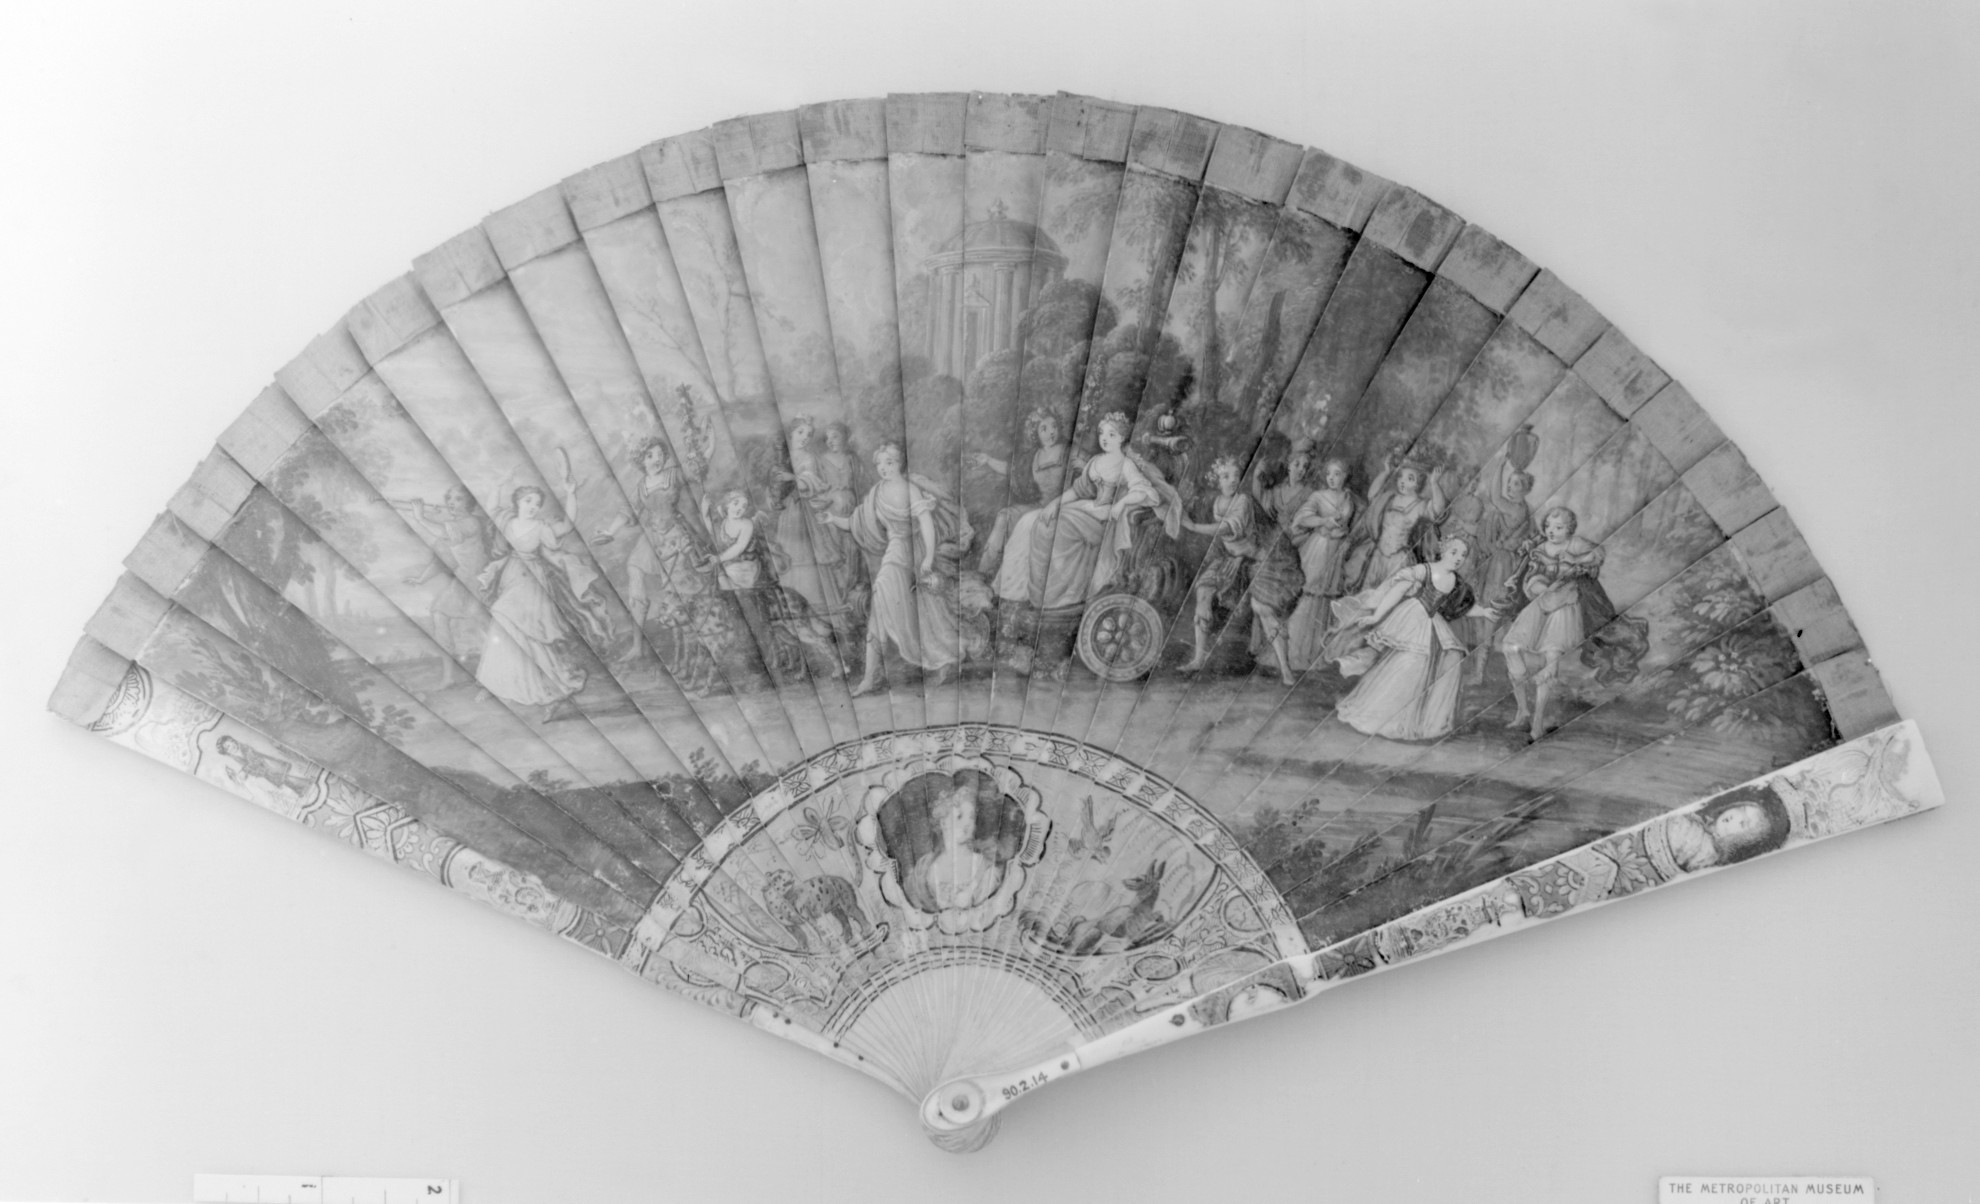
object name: fan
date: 1701-1733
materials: ivory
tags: animals,women,carriages